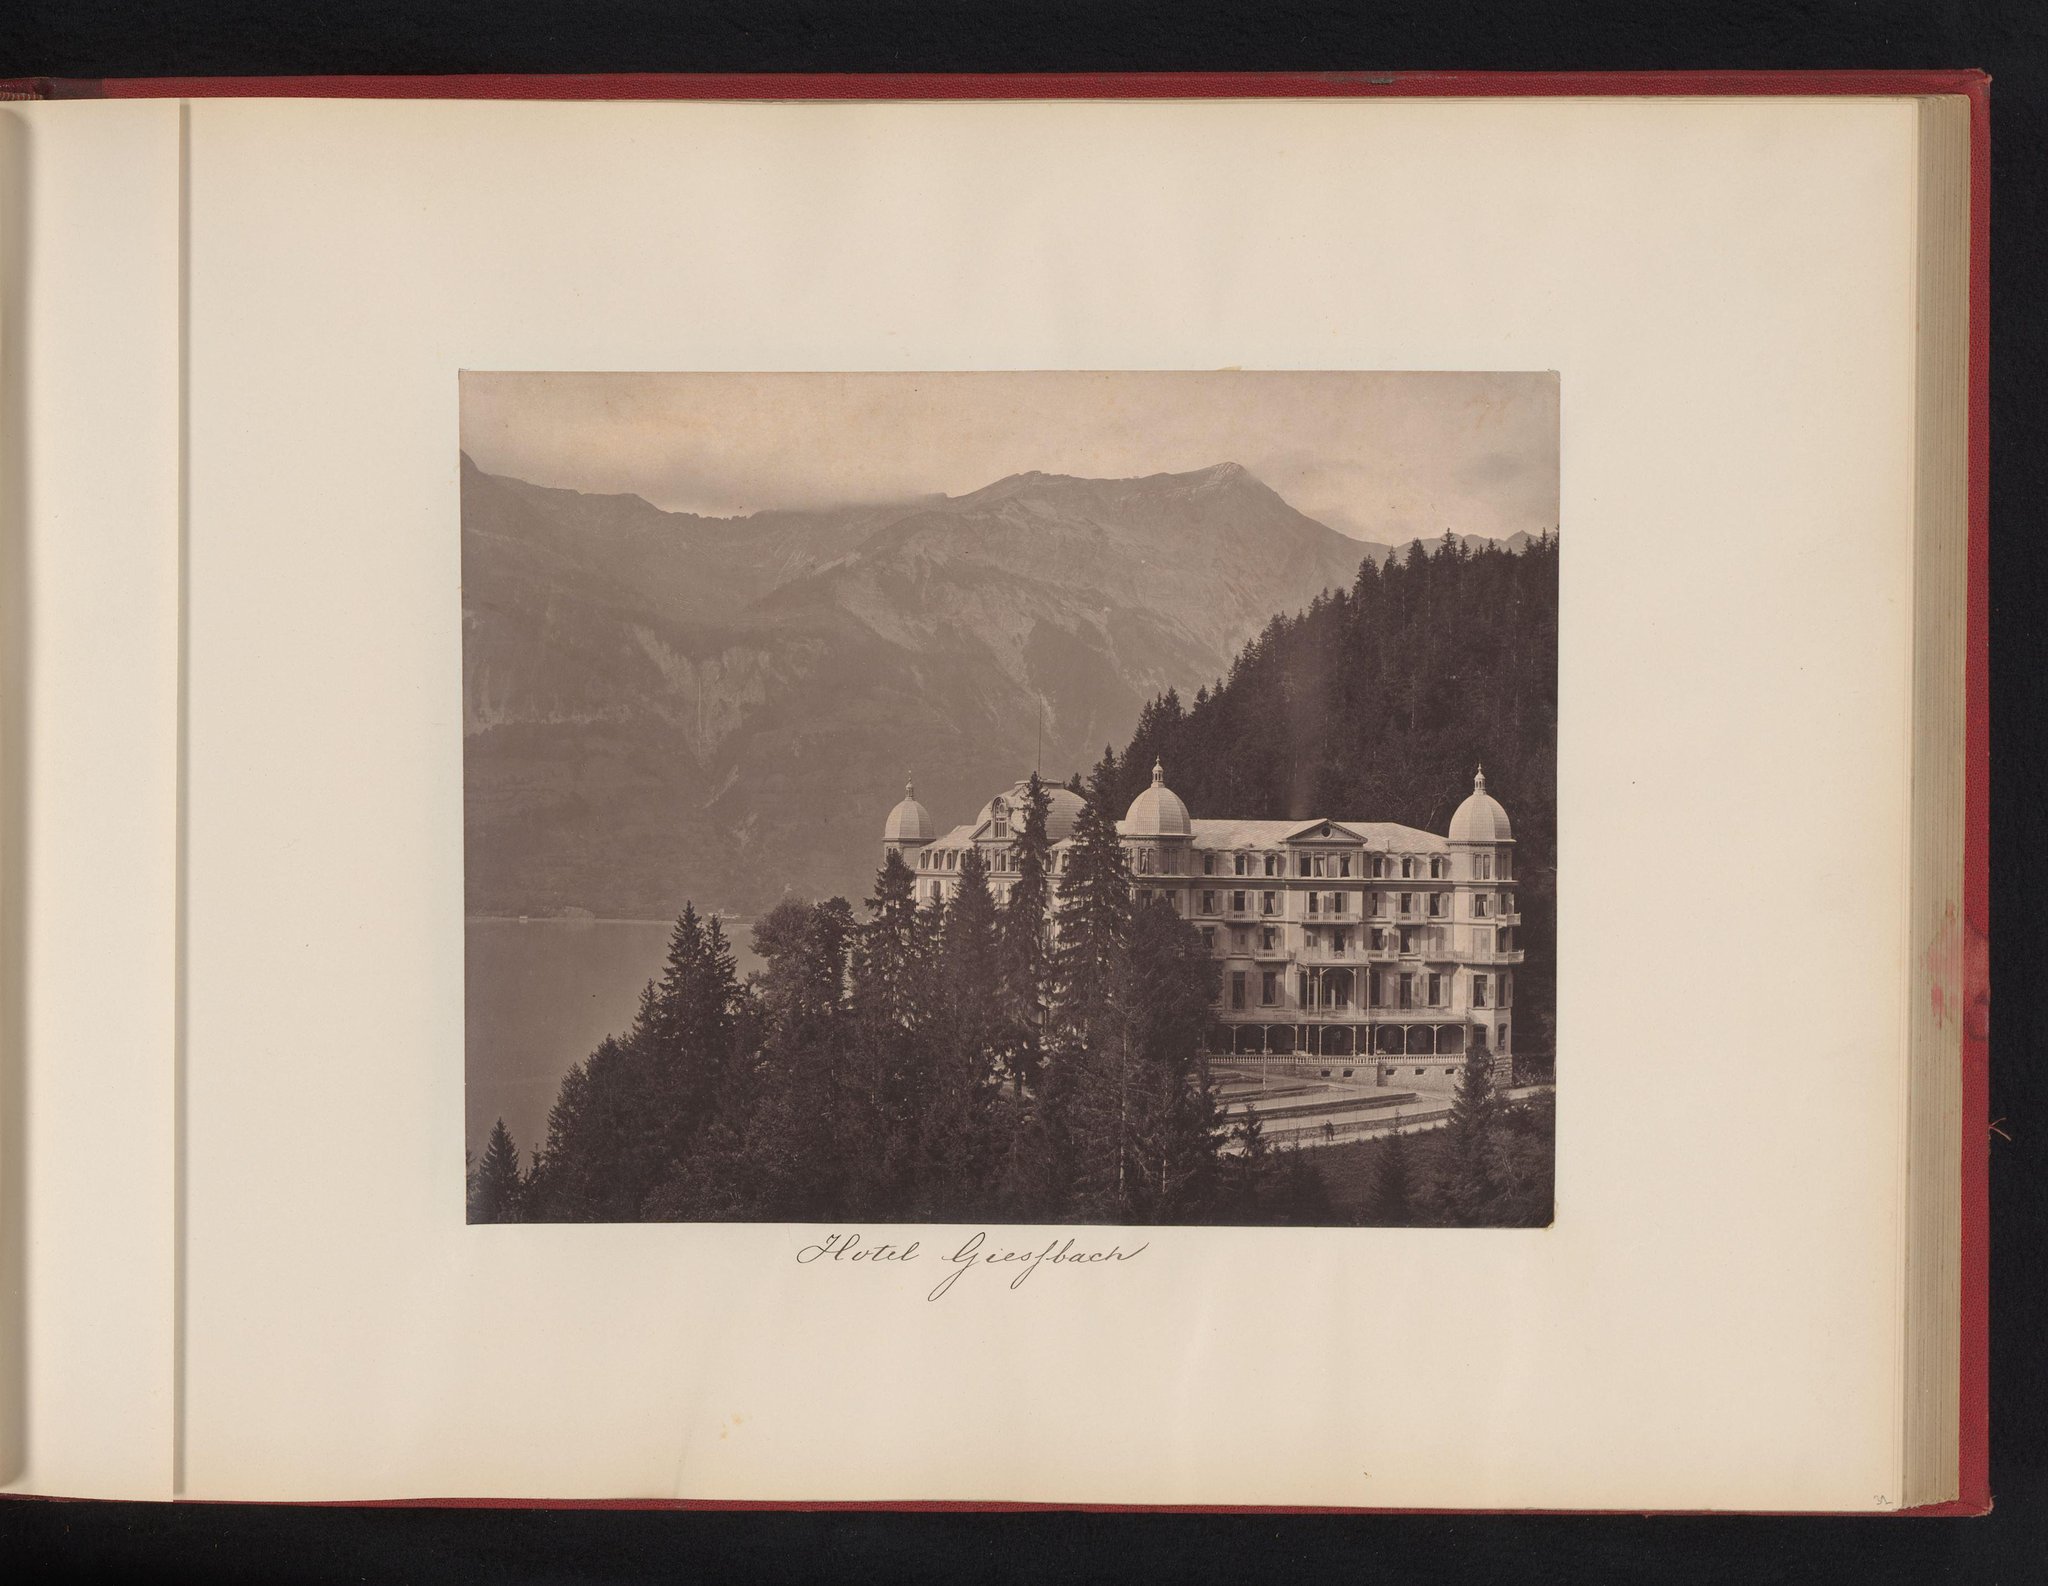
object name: photograph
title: Gezicht op Hotel Giessbach te Brienz, Zwitserland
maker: Anonymous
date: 1880-1900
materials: photographic support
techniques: albumen print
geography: brienz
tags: hotel, hostelry, inn